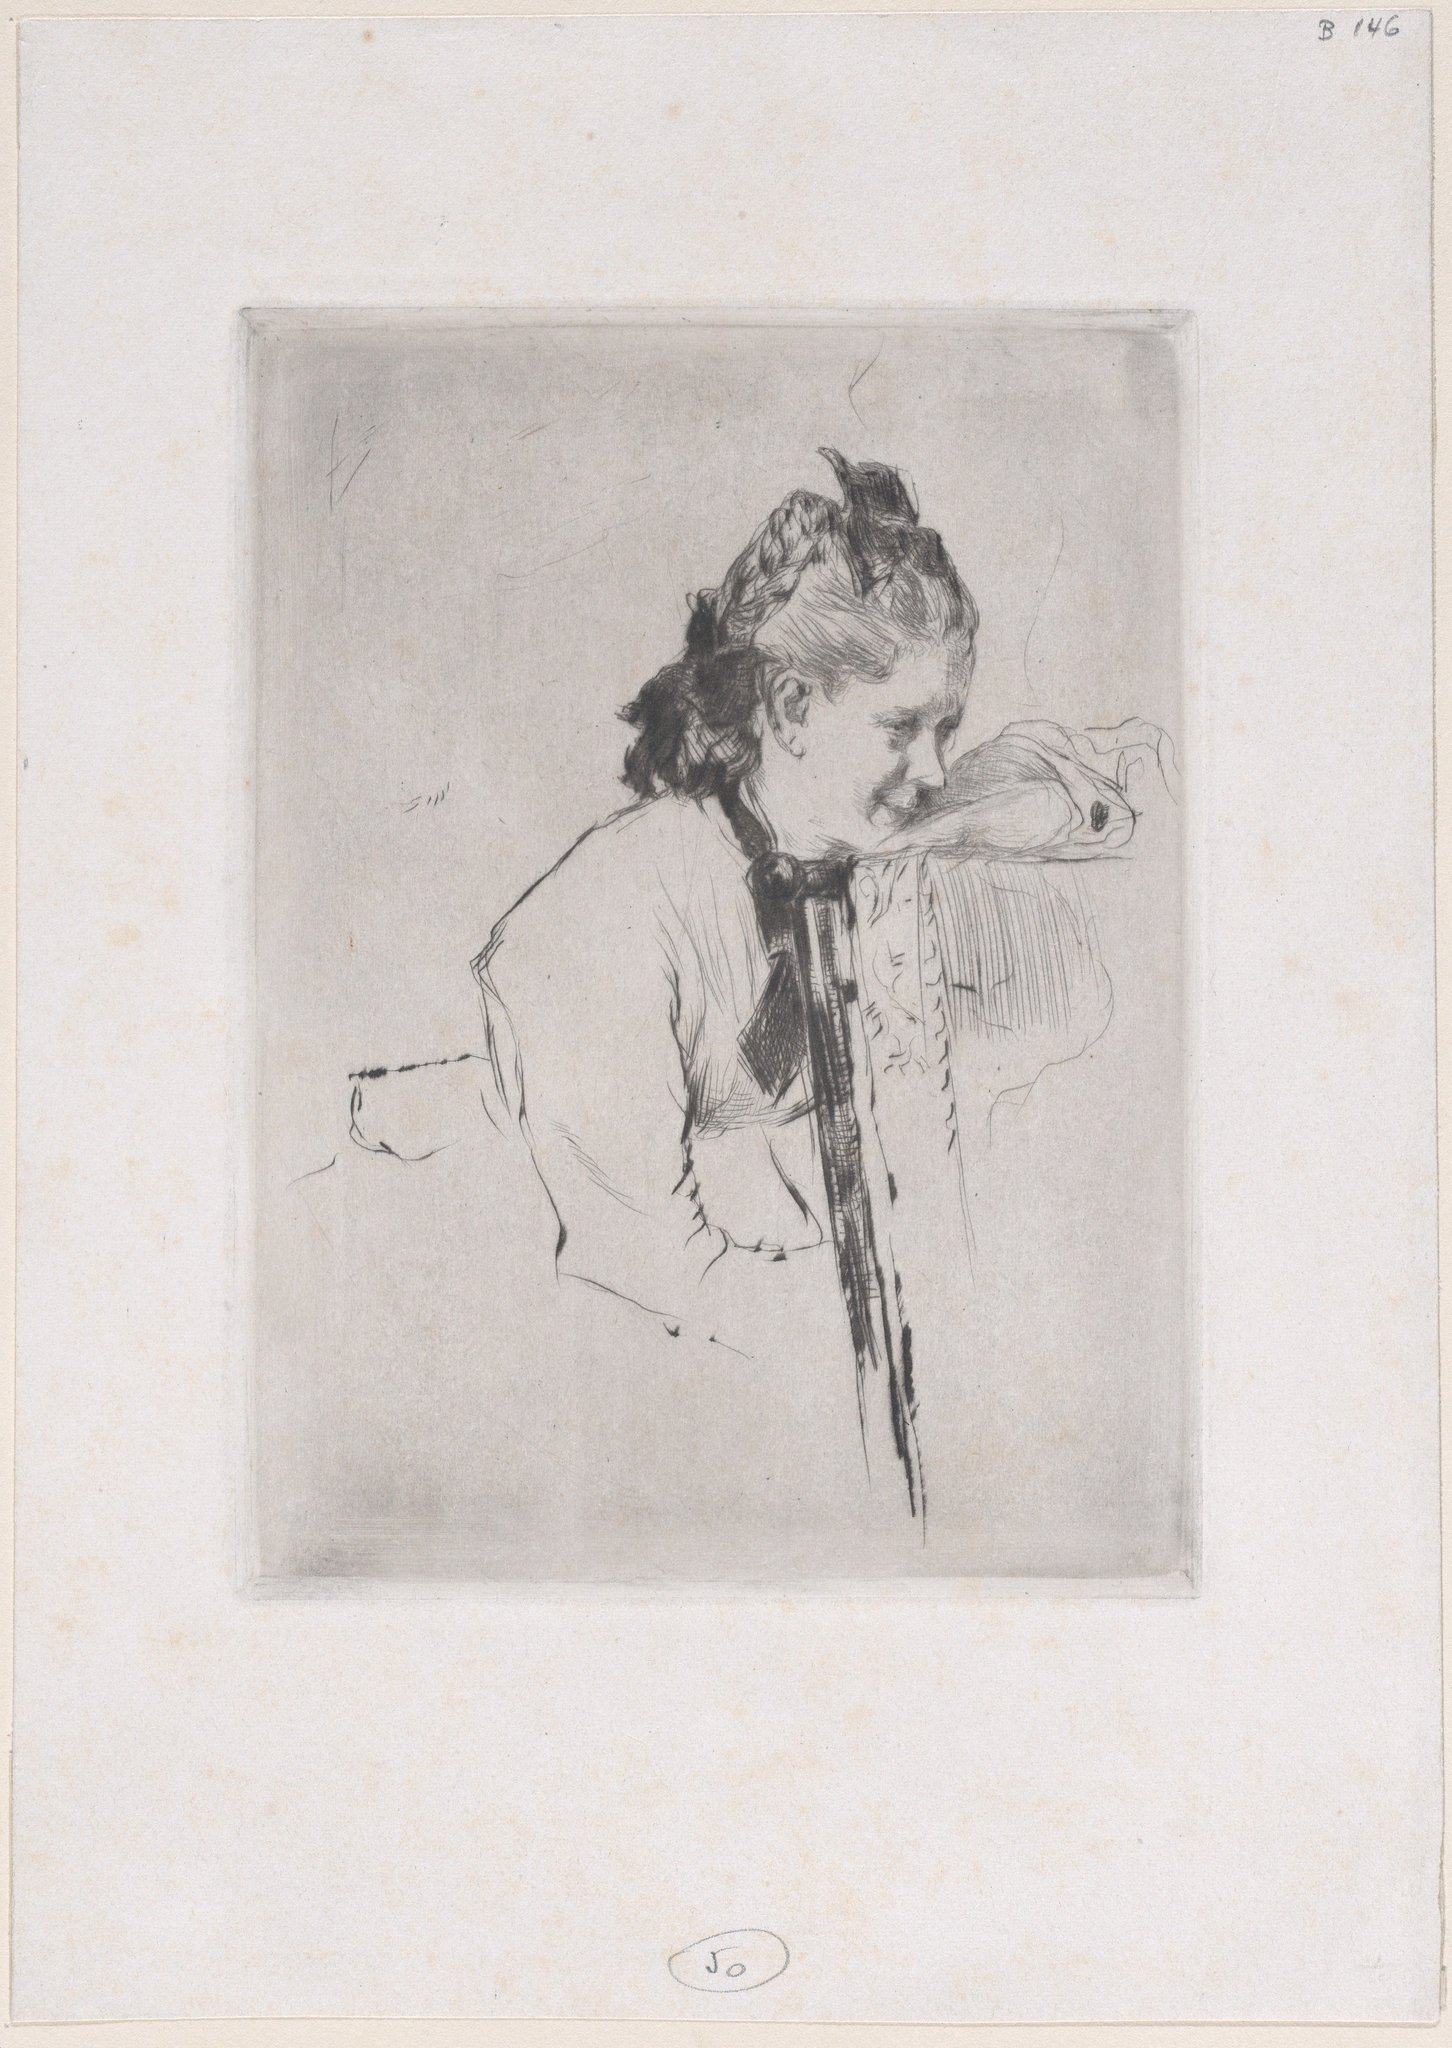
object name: print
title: Femme de métier (étude de jeune fille appuyée sur une chaise)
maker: marcellin desboutin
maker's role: artist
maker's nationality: french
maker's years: 1823-1902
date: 1889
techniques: drypoint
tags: women